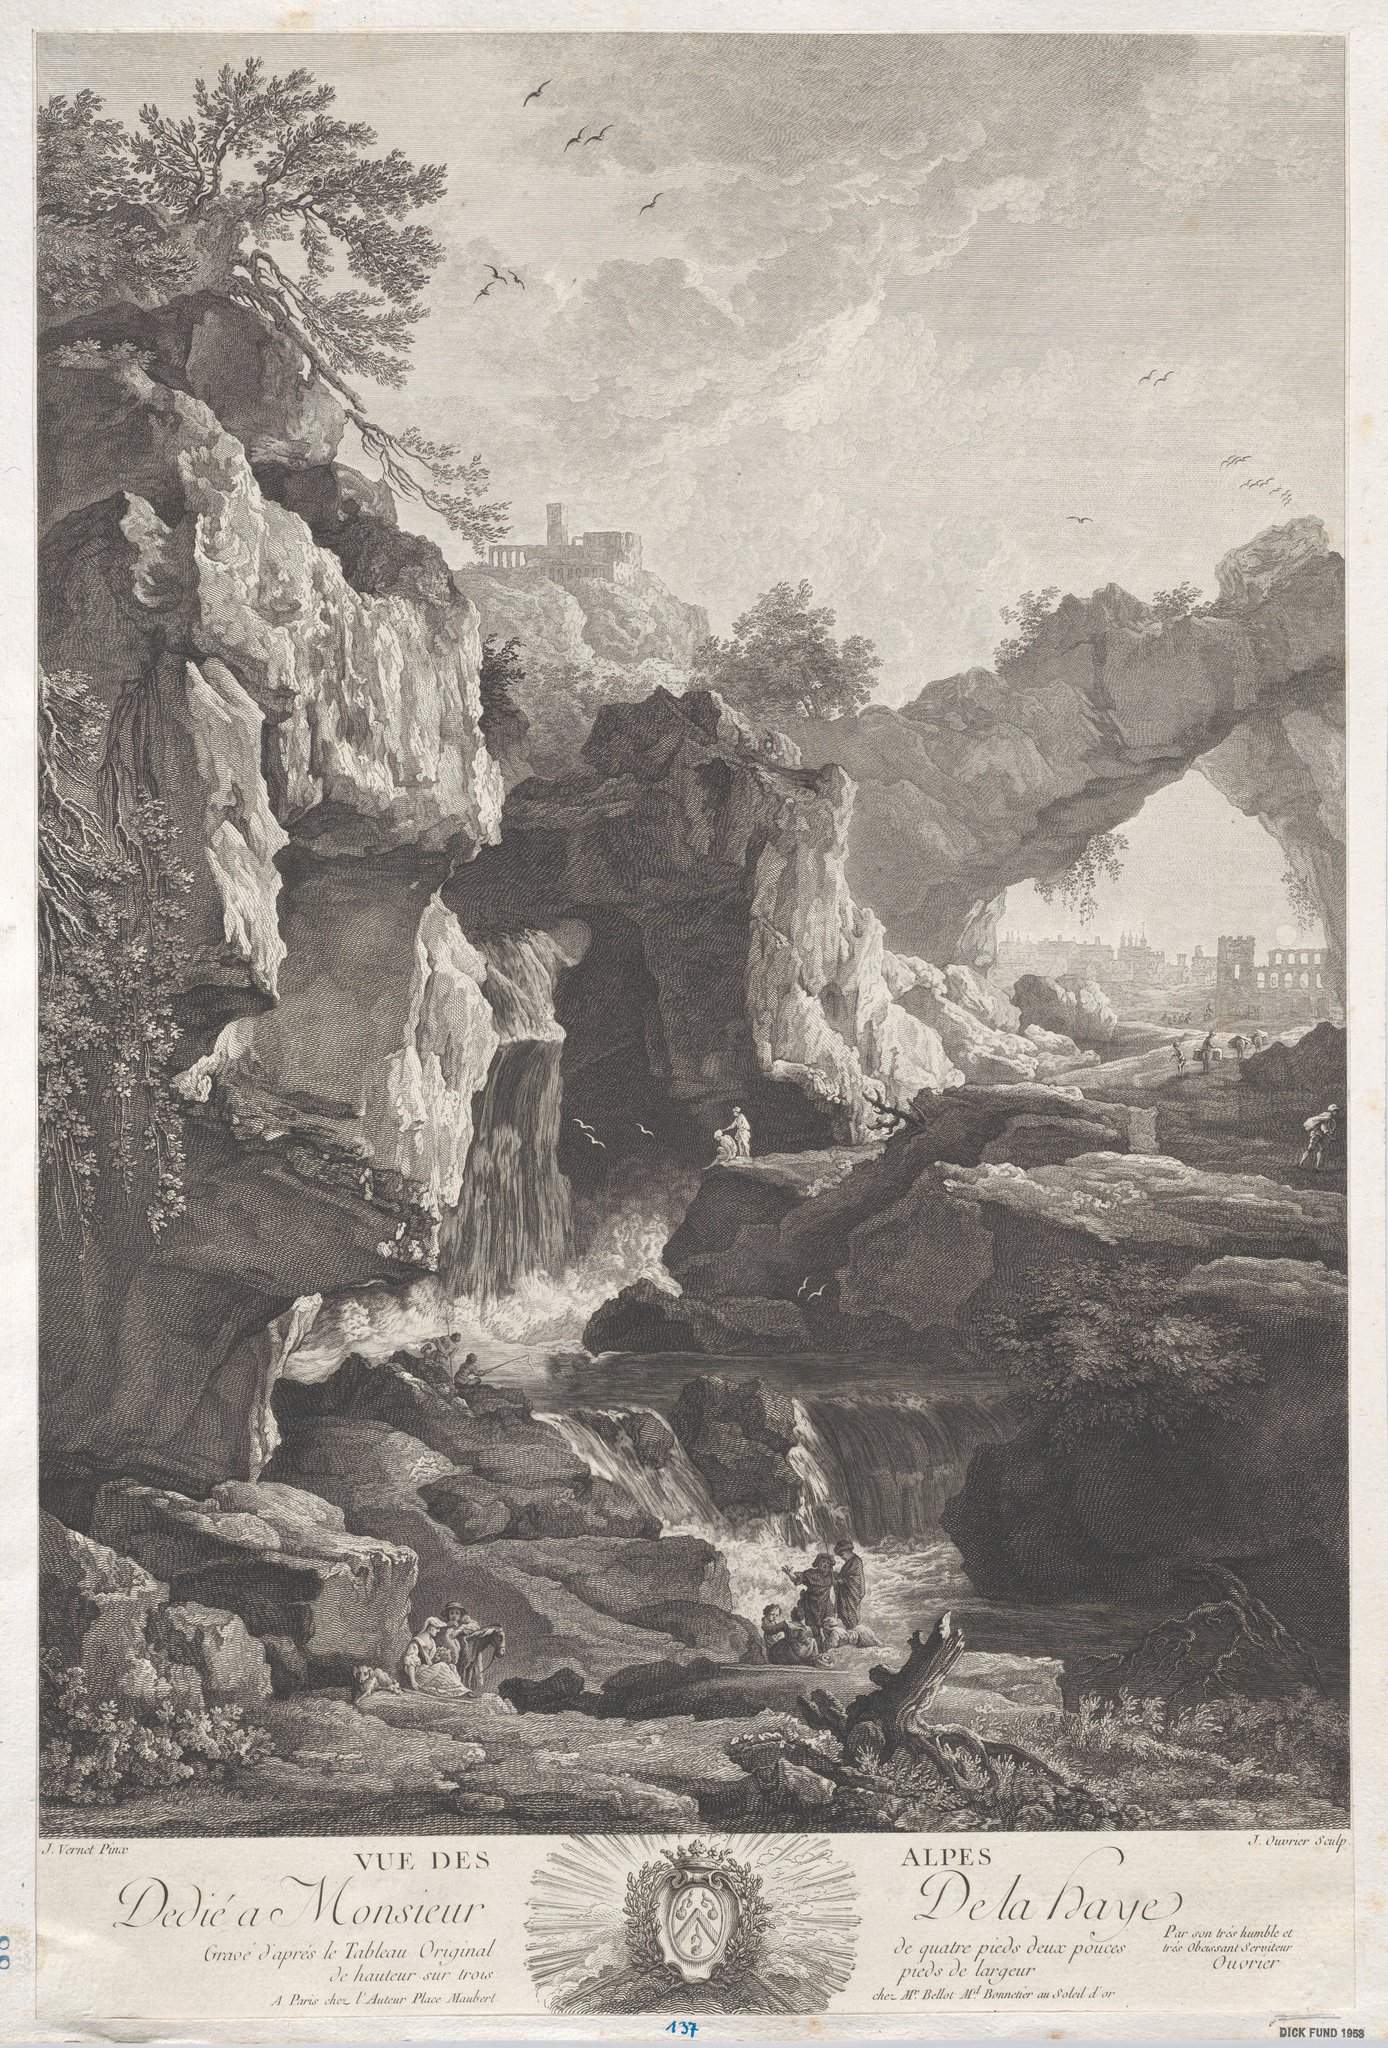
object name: print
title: View of the Alpes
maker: joseph vernet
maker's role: artist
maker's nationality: french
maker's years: 1714-1789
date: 1760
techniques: engraving